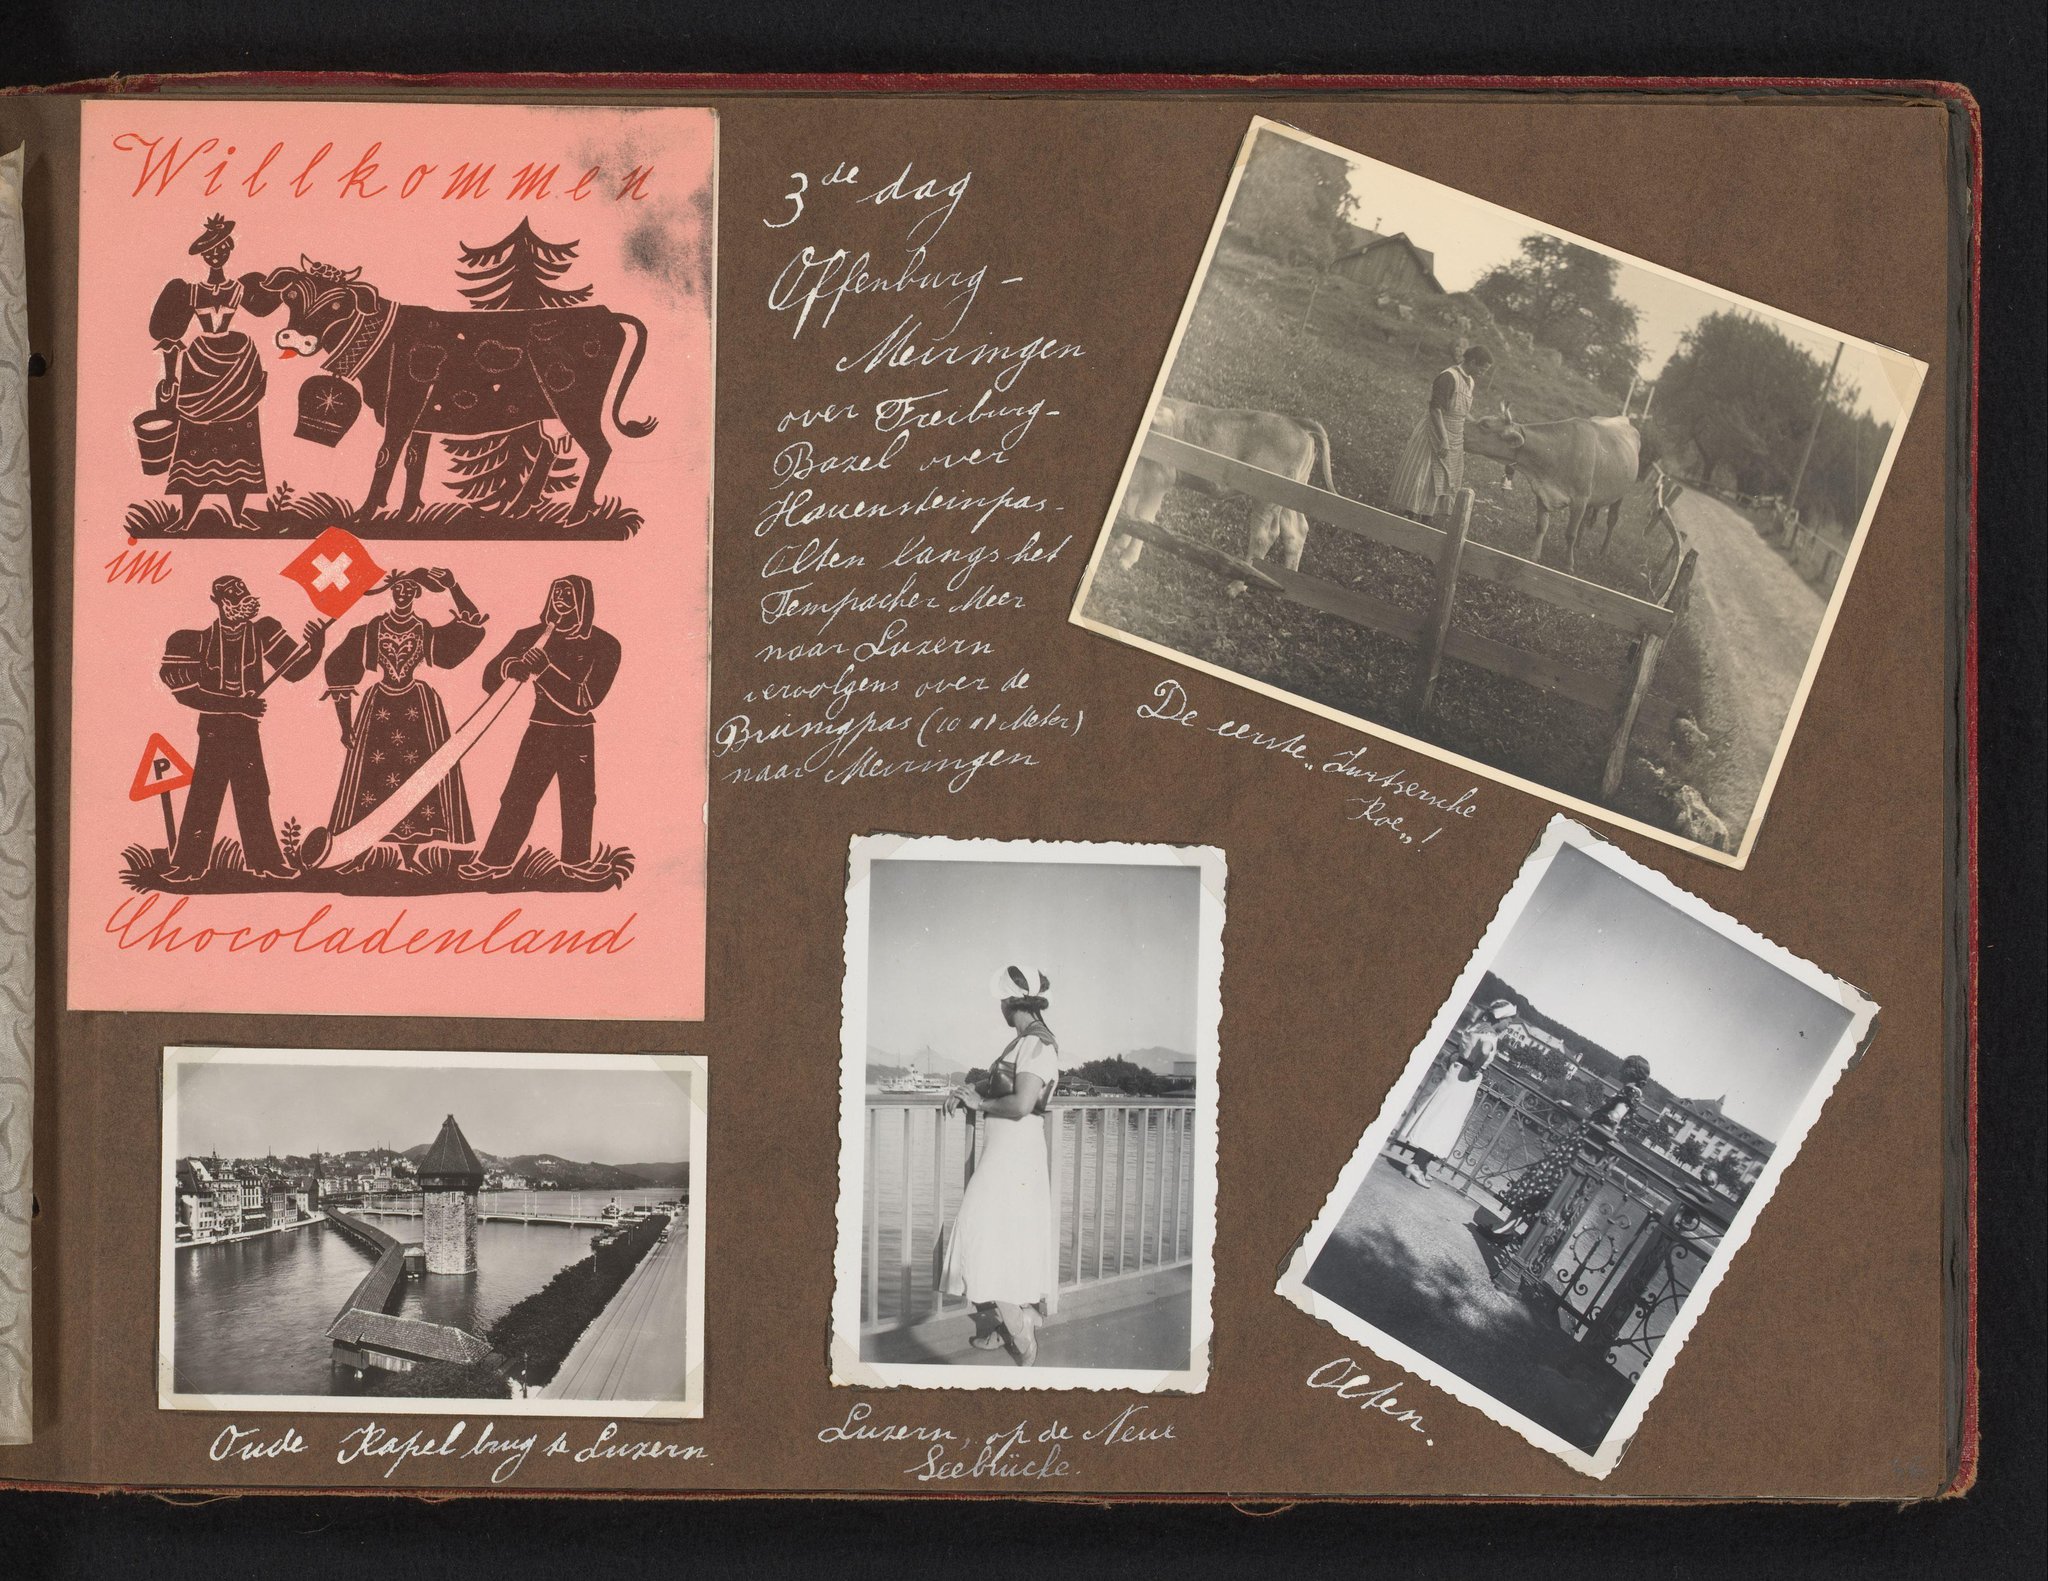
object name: folder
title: 3de dag: Offenburg-Meiringen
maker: Anonymous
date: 1908-1937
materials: paper, photographic support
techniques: gelatin silver print, printed materials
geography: switzerland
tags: city-view in general; 'veduta', outing, pleasure trip, switzerland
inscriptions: inscription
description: Albumblad met vier foto's onderweg in Zwitserland en een kleurenfolder 'Willkommen im Chocoladenland'. Verslag van een elfdaagse groepsreis per autobus naar Zwitserland van 2 tot en met 12 augustus 1937. Onderdeel van het reisalbum van de familie Van den Broek 1935-1937.